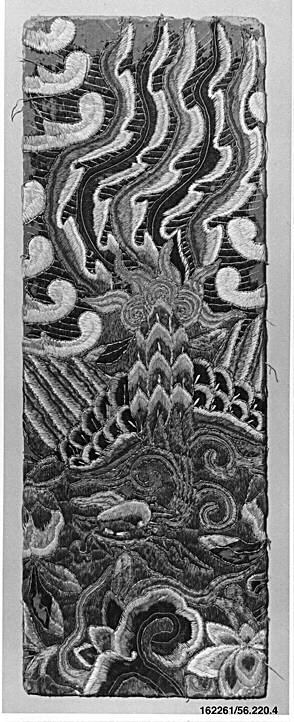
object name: sutra cover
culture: chinese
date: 1368-1644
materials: metal thread, silk